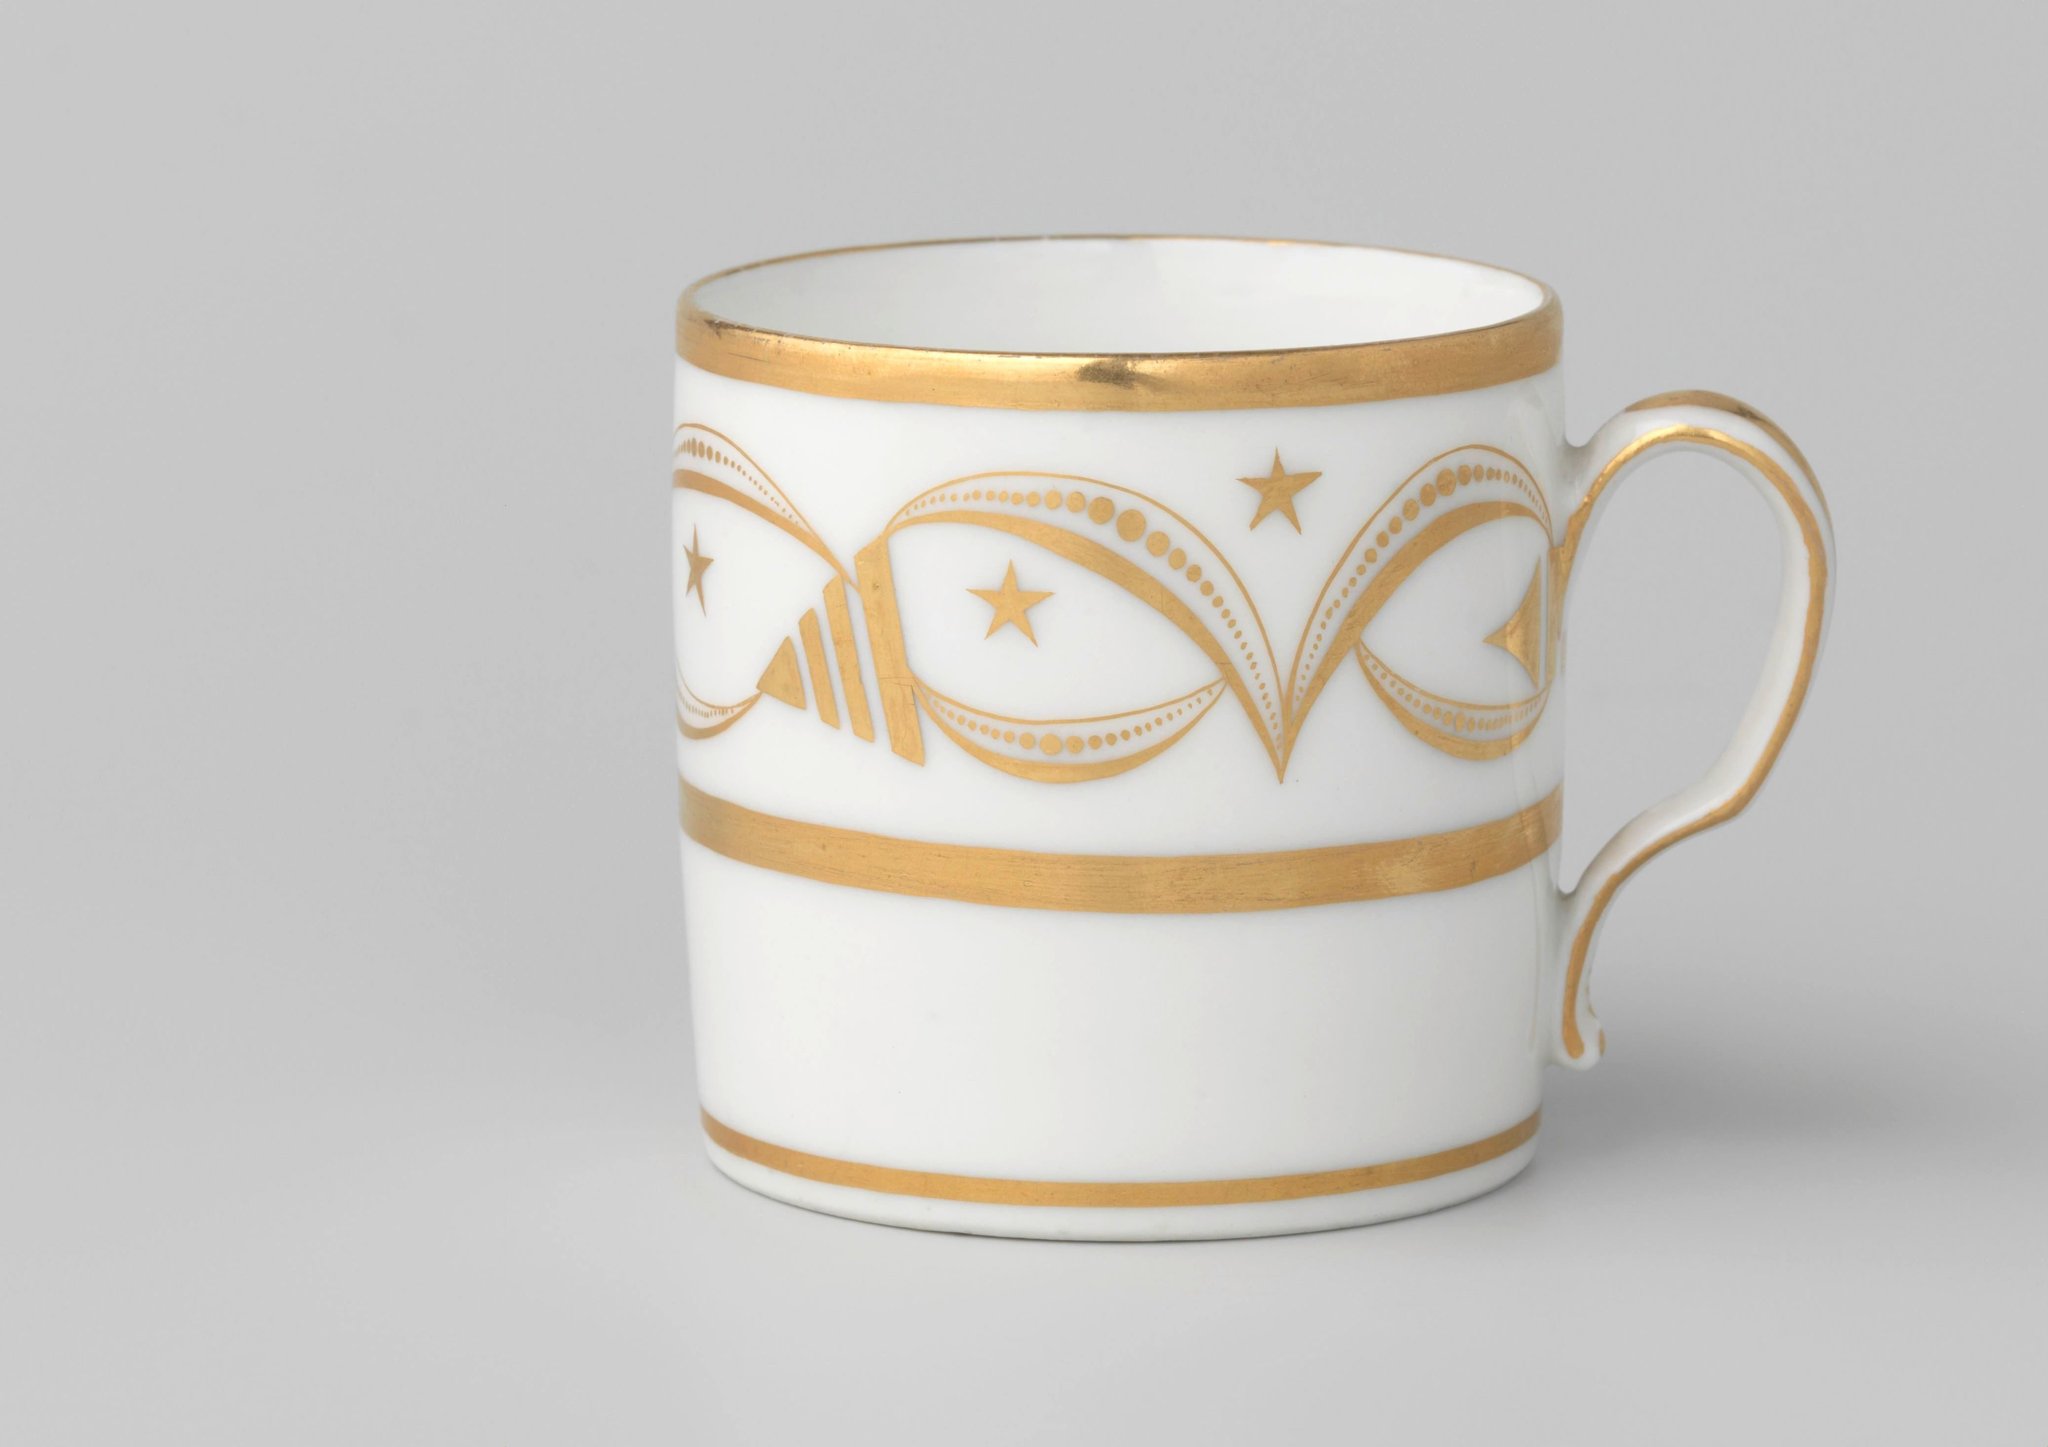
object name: service set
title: Cup with an ornamental border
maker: Anonymous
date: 1800-1824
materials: glaze, gold, paint, porcelain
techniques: firing, forming, gilding, turning, vitrification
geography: france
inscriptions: mark: ‘C’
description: Kop van porselein, recht model met oor, versierd met gouden banden waartussen een slingermotief dat wordt gevormd door halvemaanvormige schijven waarin punten. De schijven worden verbonden door driehoeken. Op de tussenliggende velden gouden sterren. Behoort tot een serie van twaalf kop-en-schotels (F-1-24), onderdeel van een koffie- en theeservies. Opmerking: van één kop is het oor afgebroken.